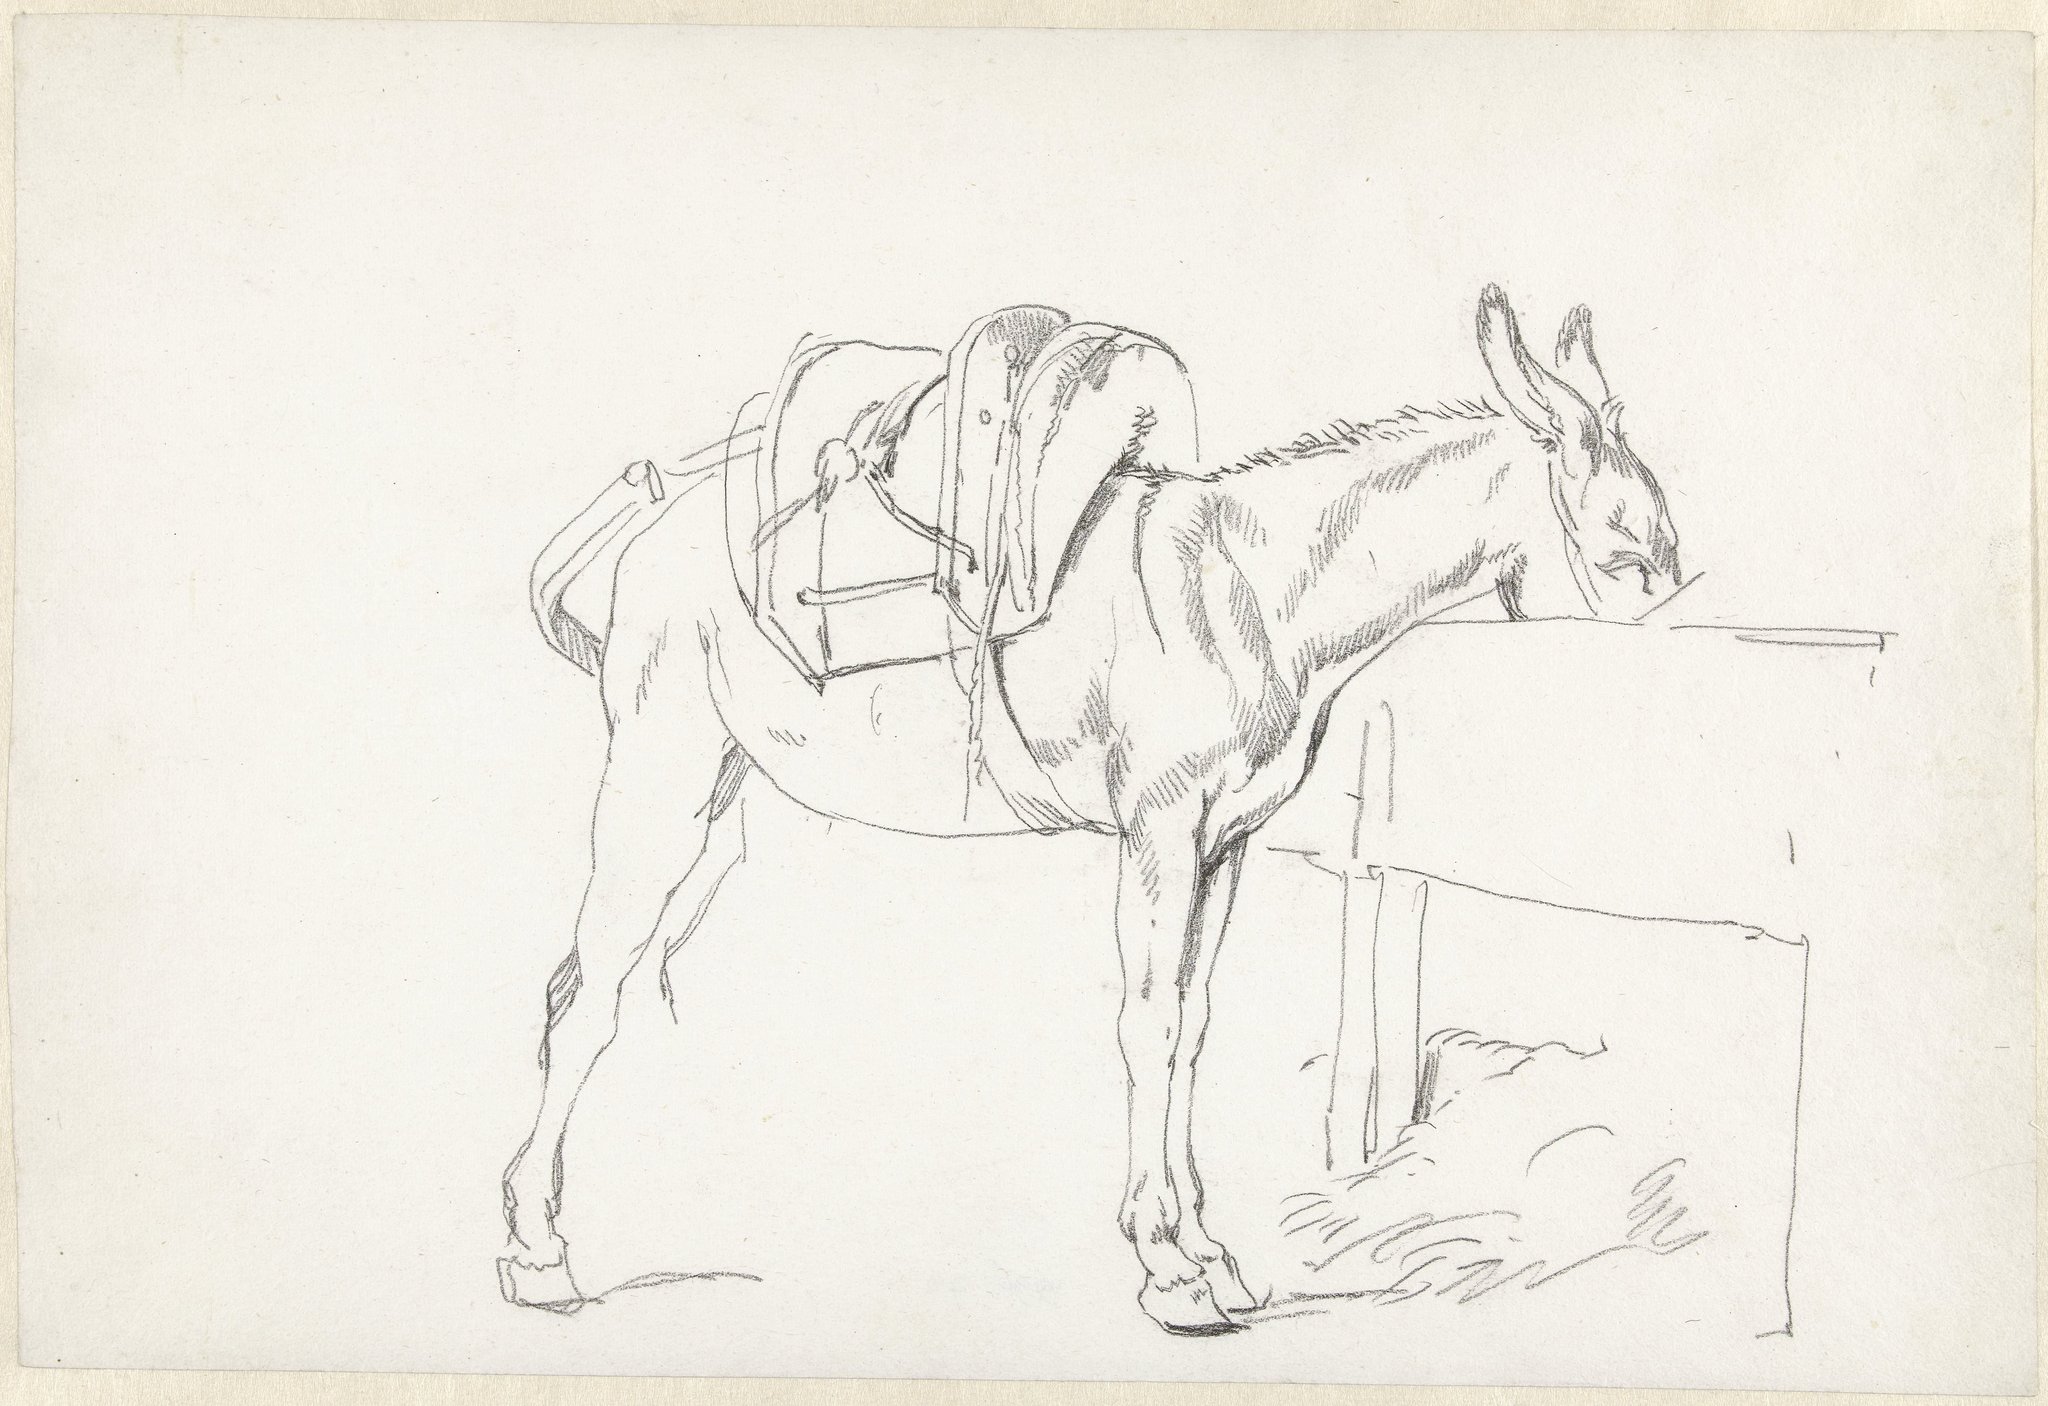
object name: drawing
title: Studie van een muilezel, etend uit een trog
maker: hendrik voogd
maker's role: draughtsman, painter, print maker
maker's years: 1768-1839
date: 1778-1839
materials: chalk, paper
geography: rome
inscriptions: inscription: ‘.’